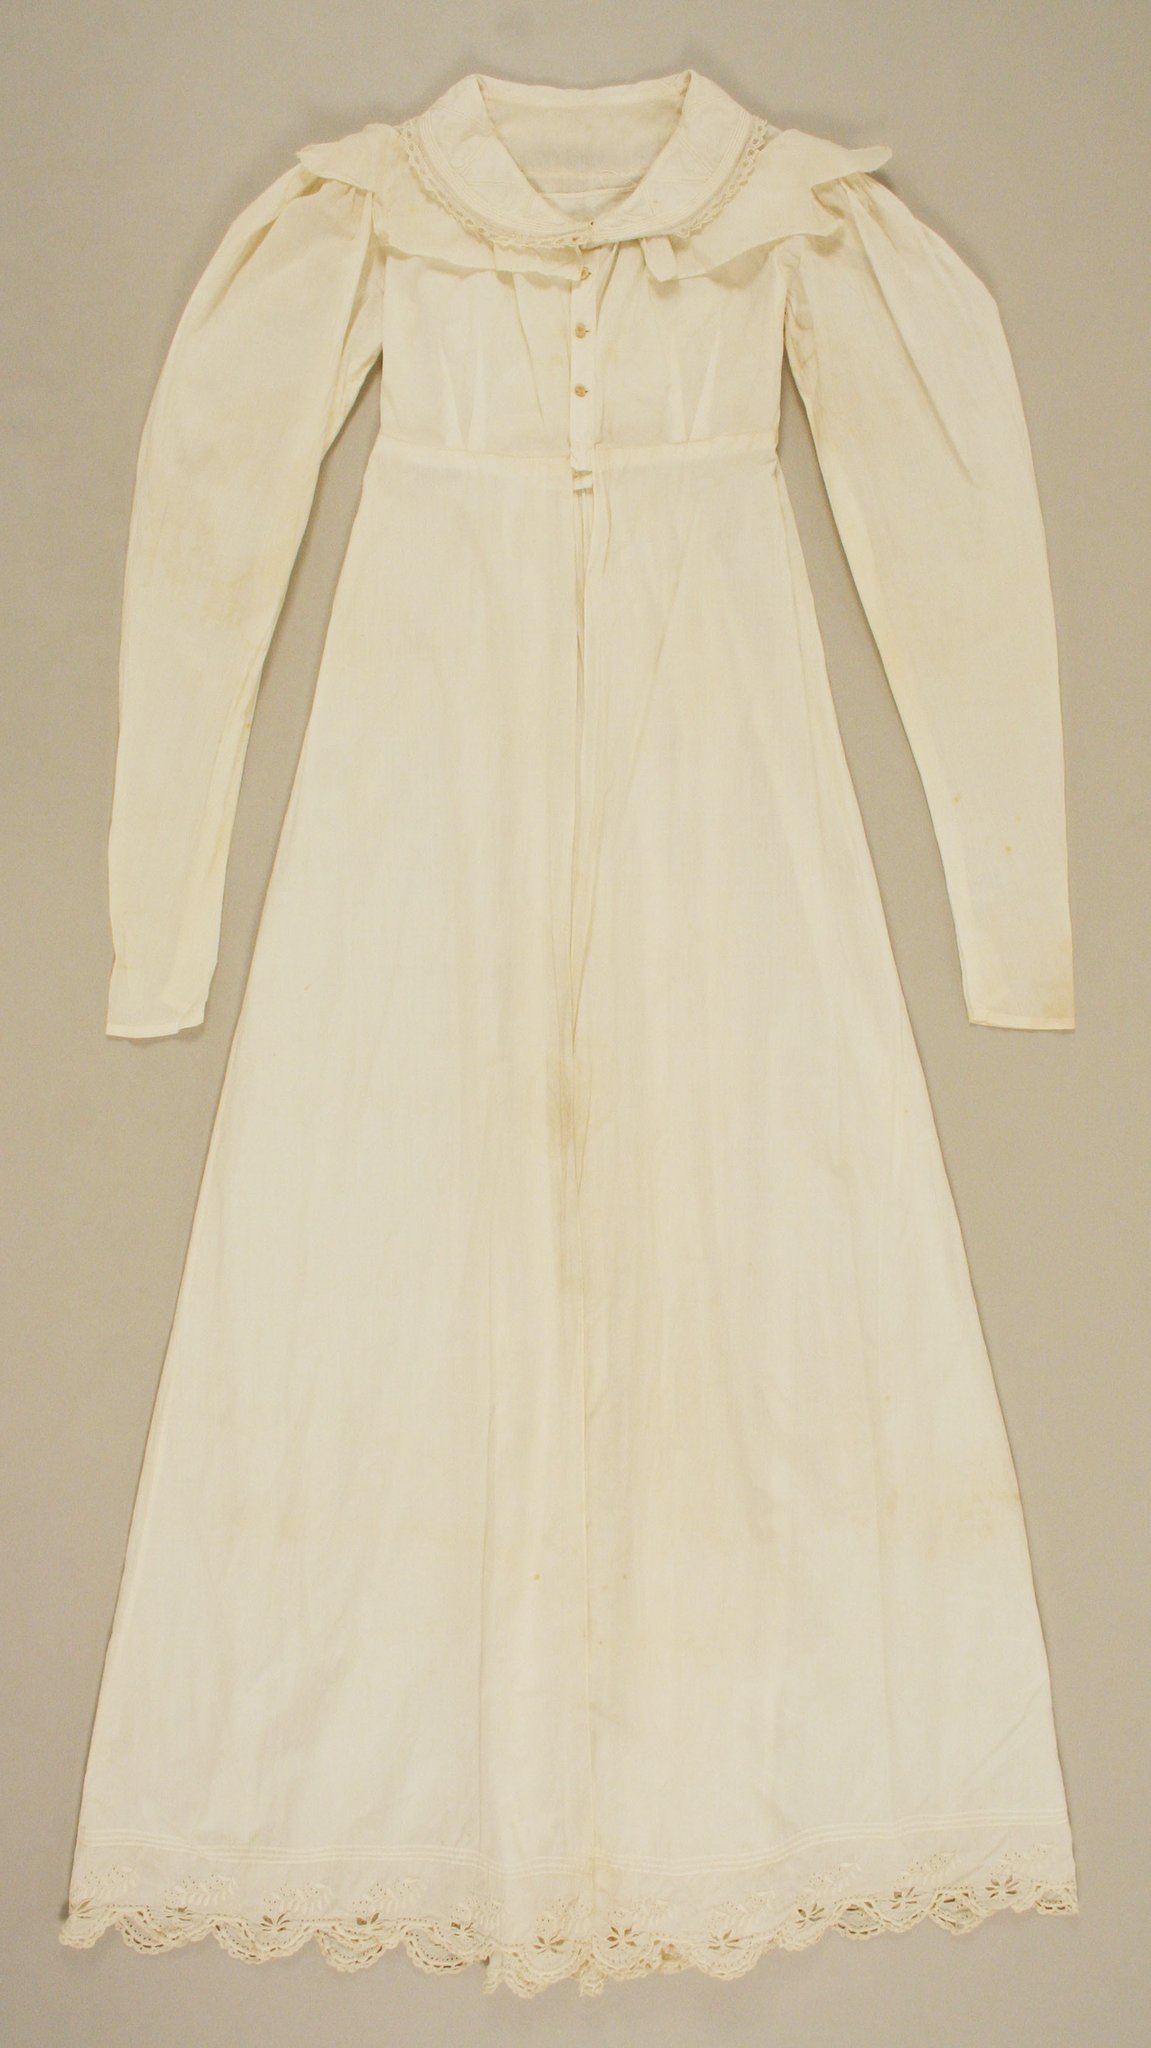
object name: peignoir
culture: american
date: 1820-1829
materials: cotton